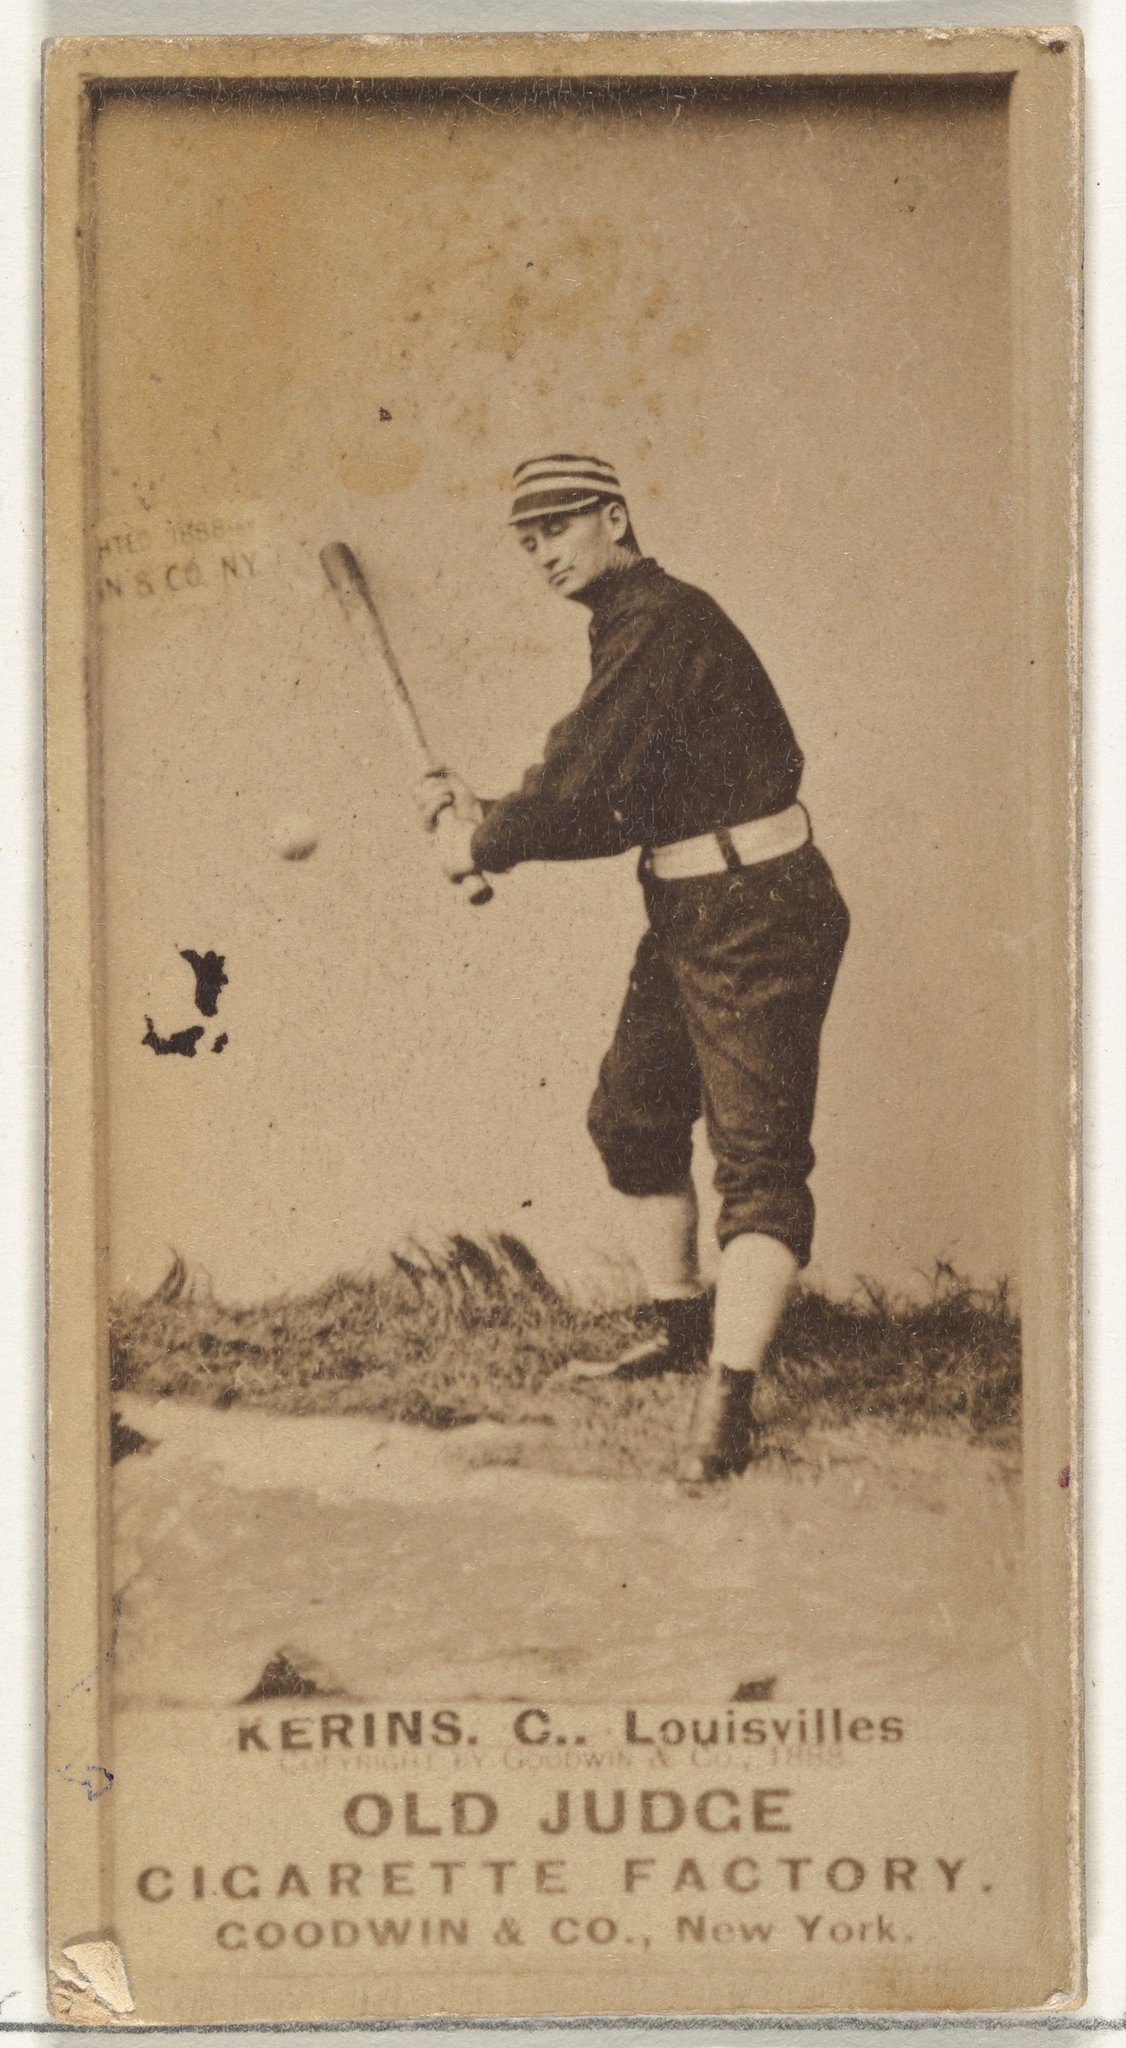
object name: baseball card, photograph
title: John Nelson Kerins, Catcher, Louisville Colonels, from the Old Judge series (N172) for Old Judge Cigarettes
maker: goodwin & company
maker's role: publisher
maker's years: 1850-1950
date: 1888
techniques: albumen silver print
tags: men,portraits,baseball,athletes